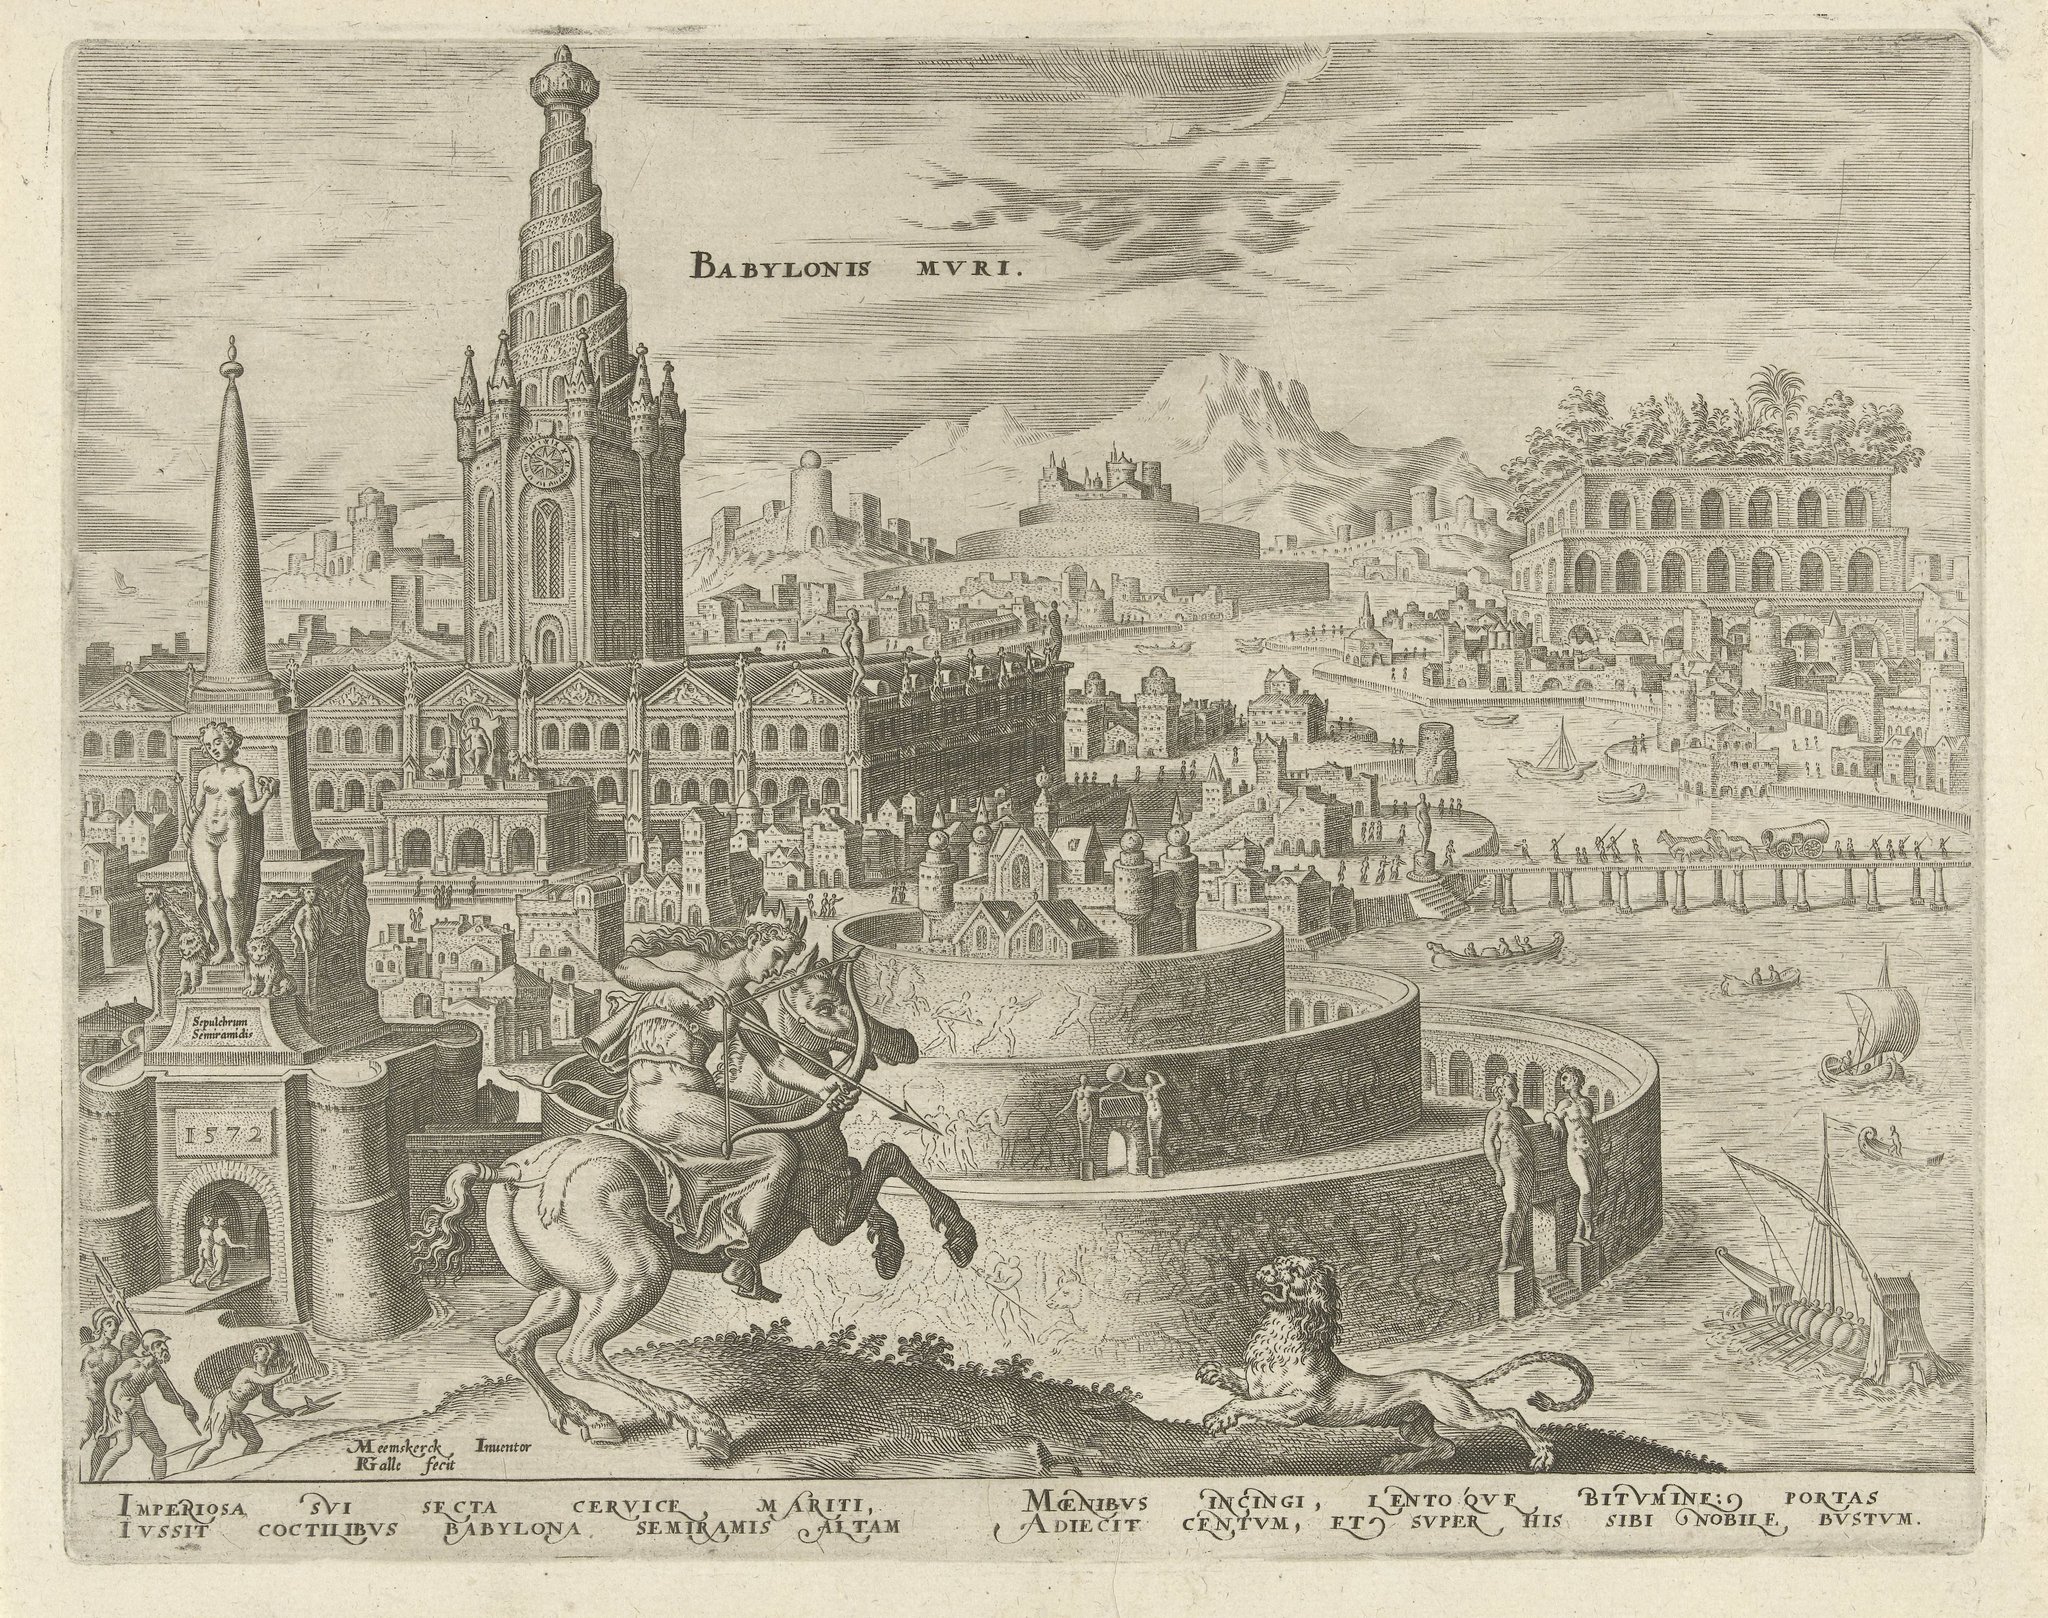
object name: print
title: Babylonis Mvri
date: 1572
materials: paper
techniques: engraving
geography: antwerp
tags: semiramis on the lion-hunt, sometimes with her husband ninus, hanging gardens of semiramis at babylon (wonder of the world)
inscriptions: collector's mark: Lugt 2228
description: De muren van Babylon, in cirkels gebouwd. Linksachter een groot gebouw met toren. Op de voorgrond koningin Semiramis als een amazone te paard. Gewapend met pijl en boog is zij is in gevecht met een leeuw. In de achtergrond de hangende tuinen van Babylon: een botanisch en architectonisch kunstwerk. De prent heeft een Latijns onderschrift en maakt deel uit van een serie over de acht wereldwonderen.